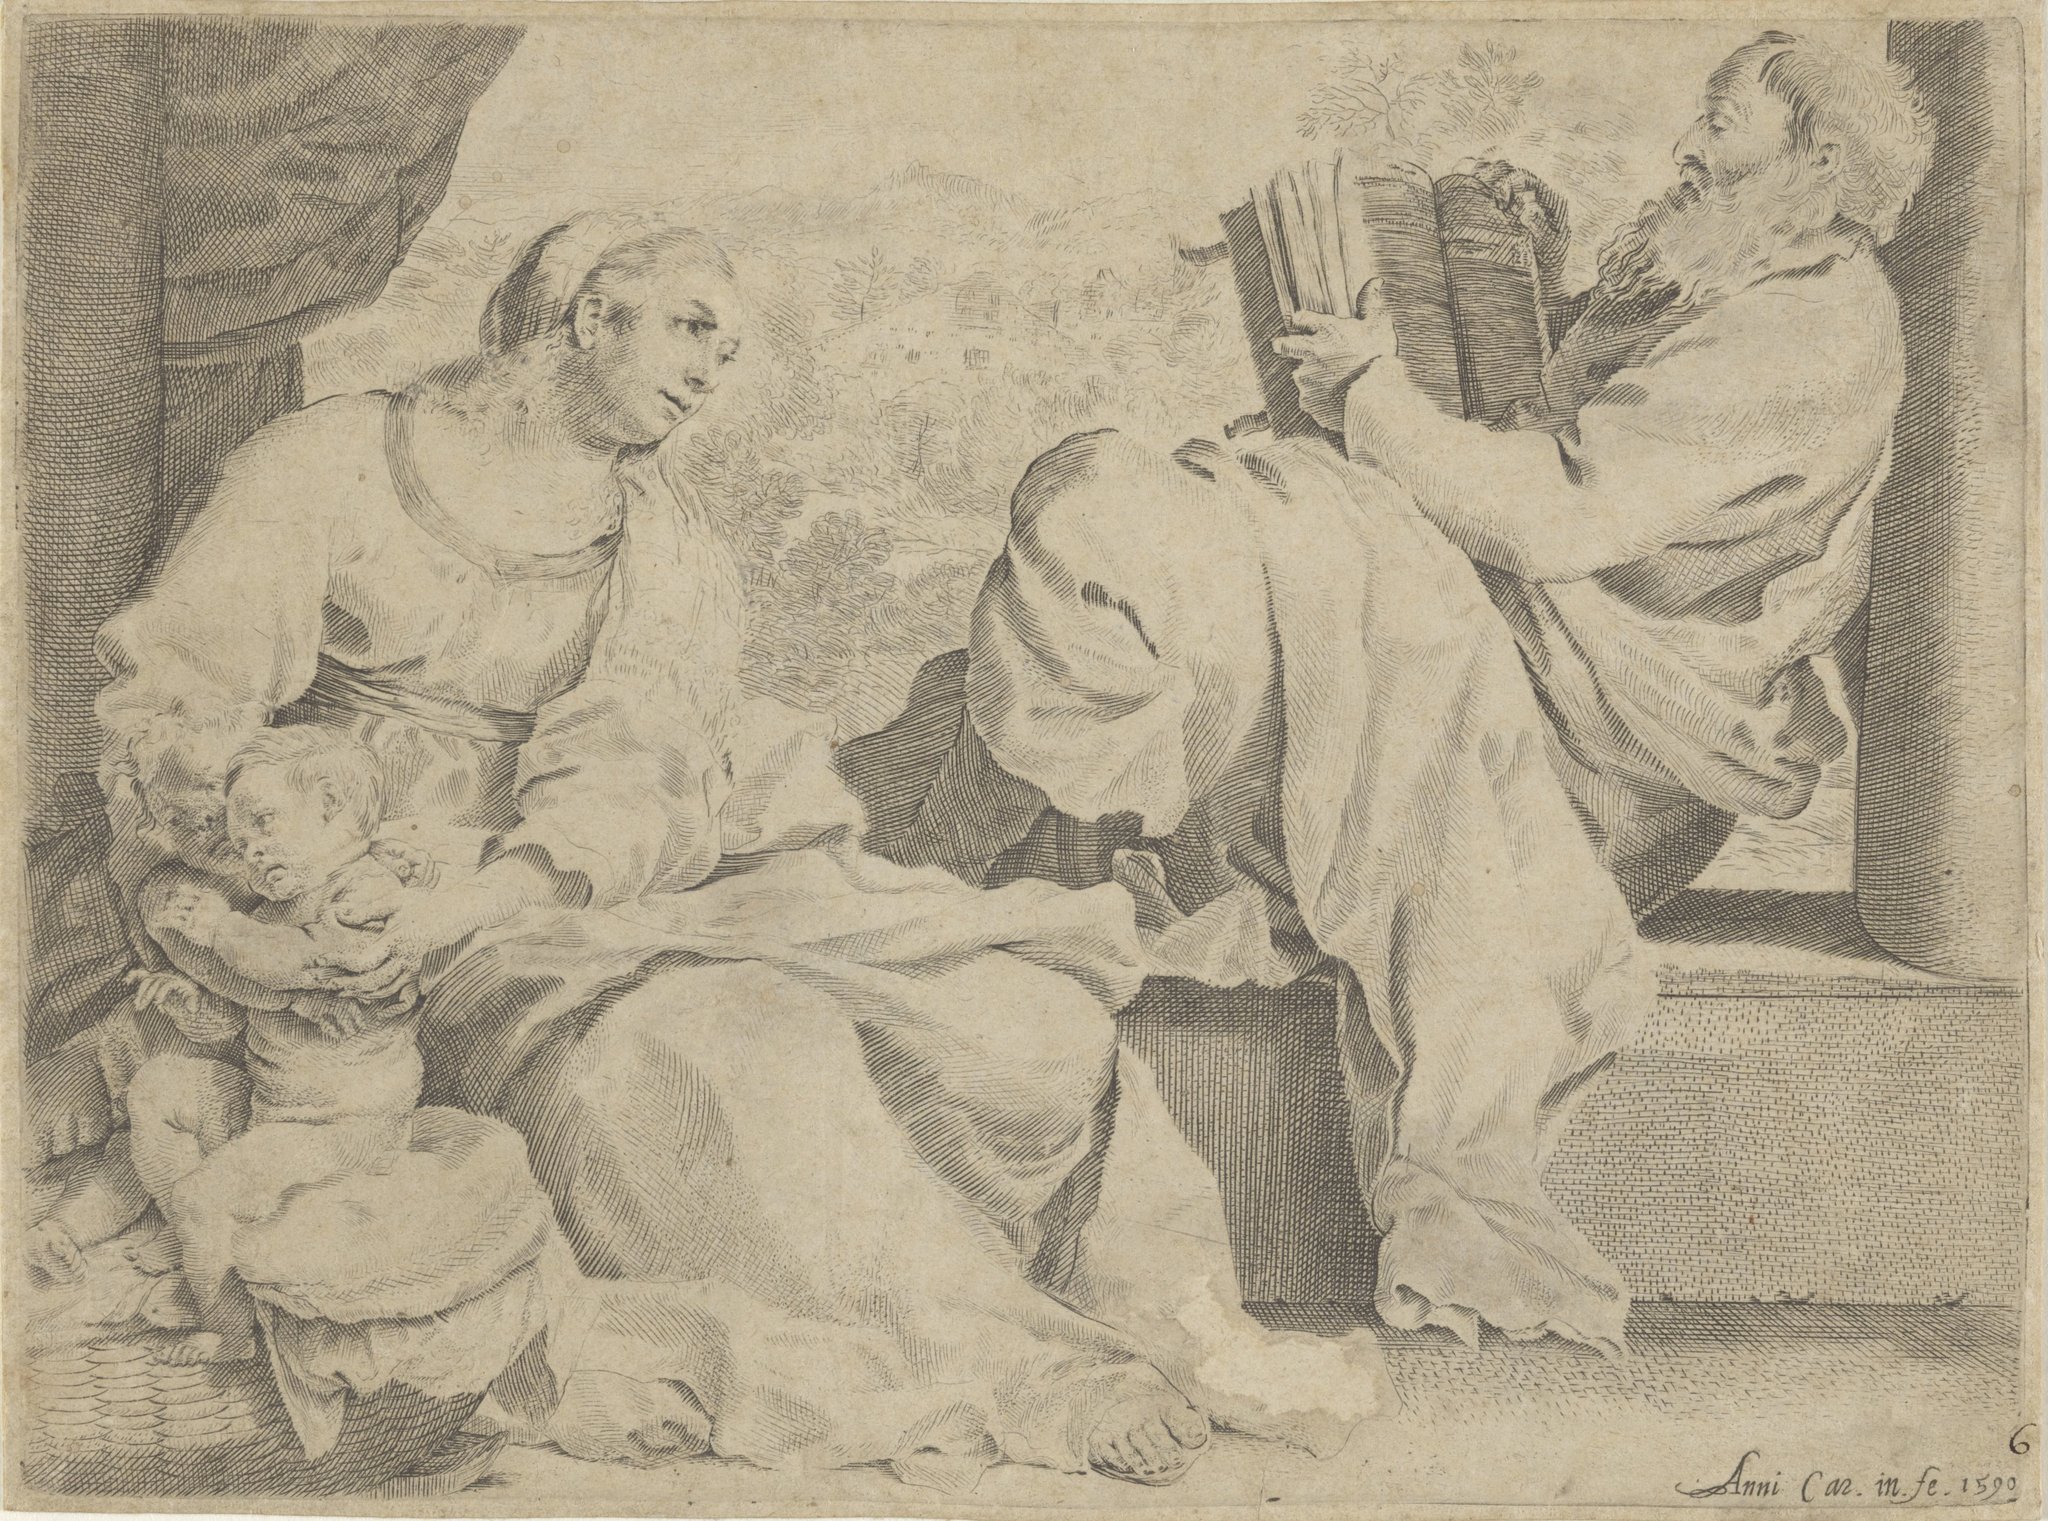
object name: print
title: Heilige Familie met de jonge Johannes de Doper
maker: annibale carracci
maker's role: draughtsman, print maker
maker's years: 1560-1609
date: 1590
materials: paper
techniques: engraving, etching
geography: italy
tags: holy family with john the baptist (as child)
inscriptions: collector's mark: Lugt 11, collector's mark: Lugt 10, number: ‘6’, collector's mark: ‘Hinloopen’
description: Maria zit op een muurtje. Voor haar zitten het Christuskind en de jonge Johannes de Doper op een mand. Rechts zit Jozef een boek te lezen. Op de achtergrond een landschap.